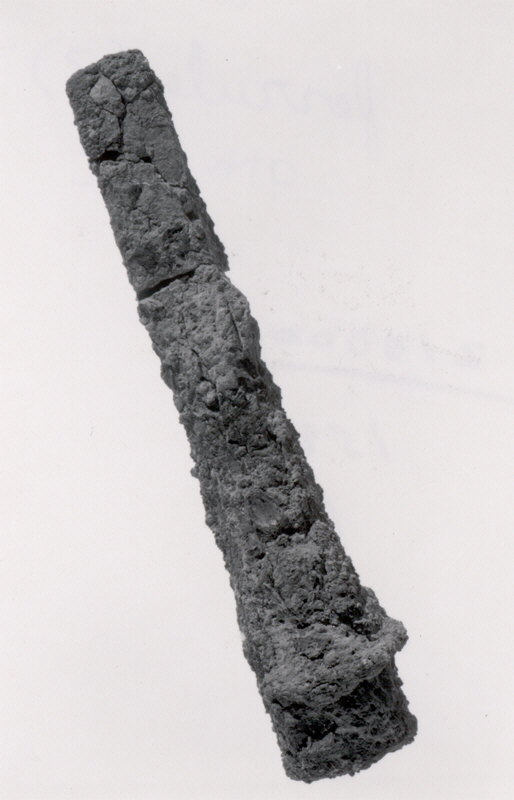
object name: ferrule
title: Ferrule (?)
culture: iranian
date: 900-801 BCE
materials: iron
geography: iran